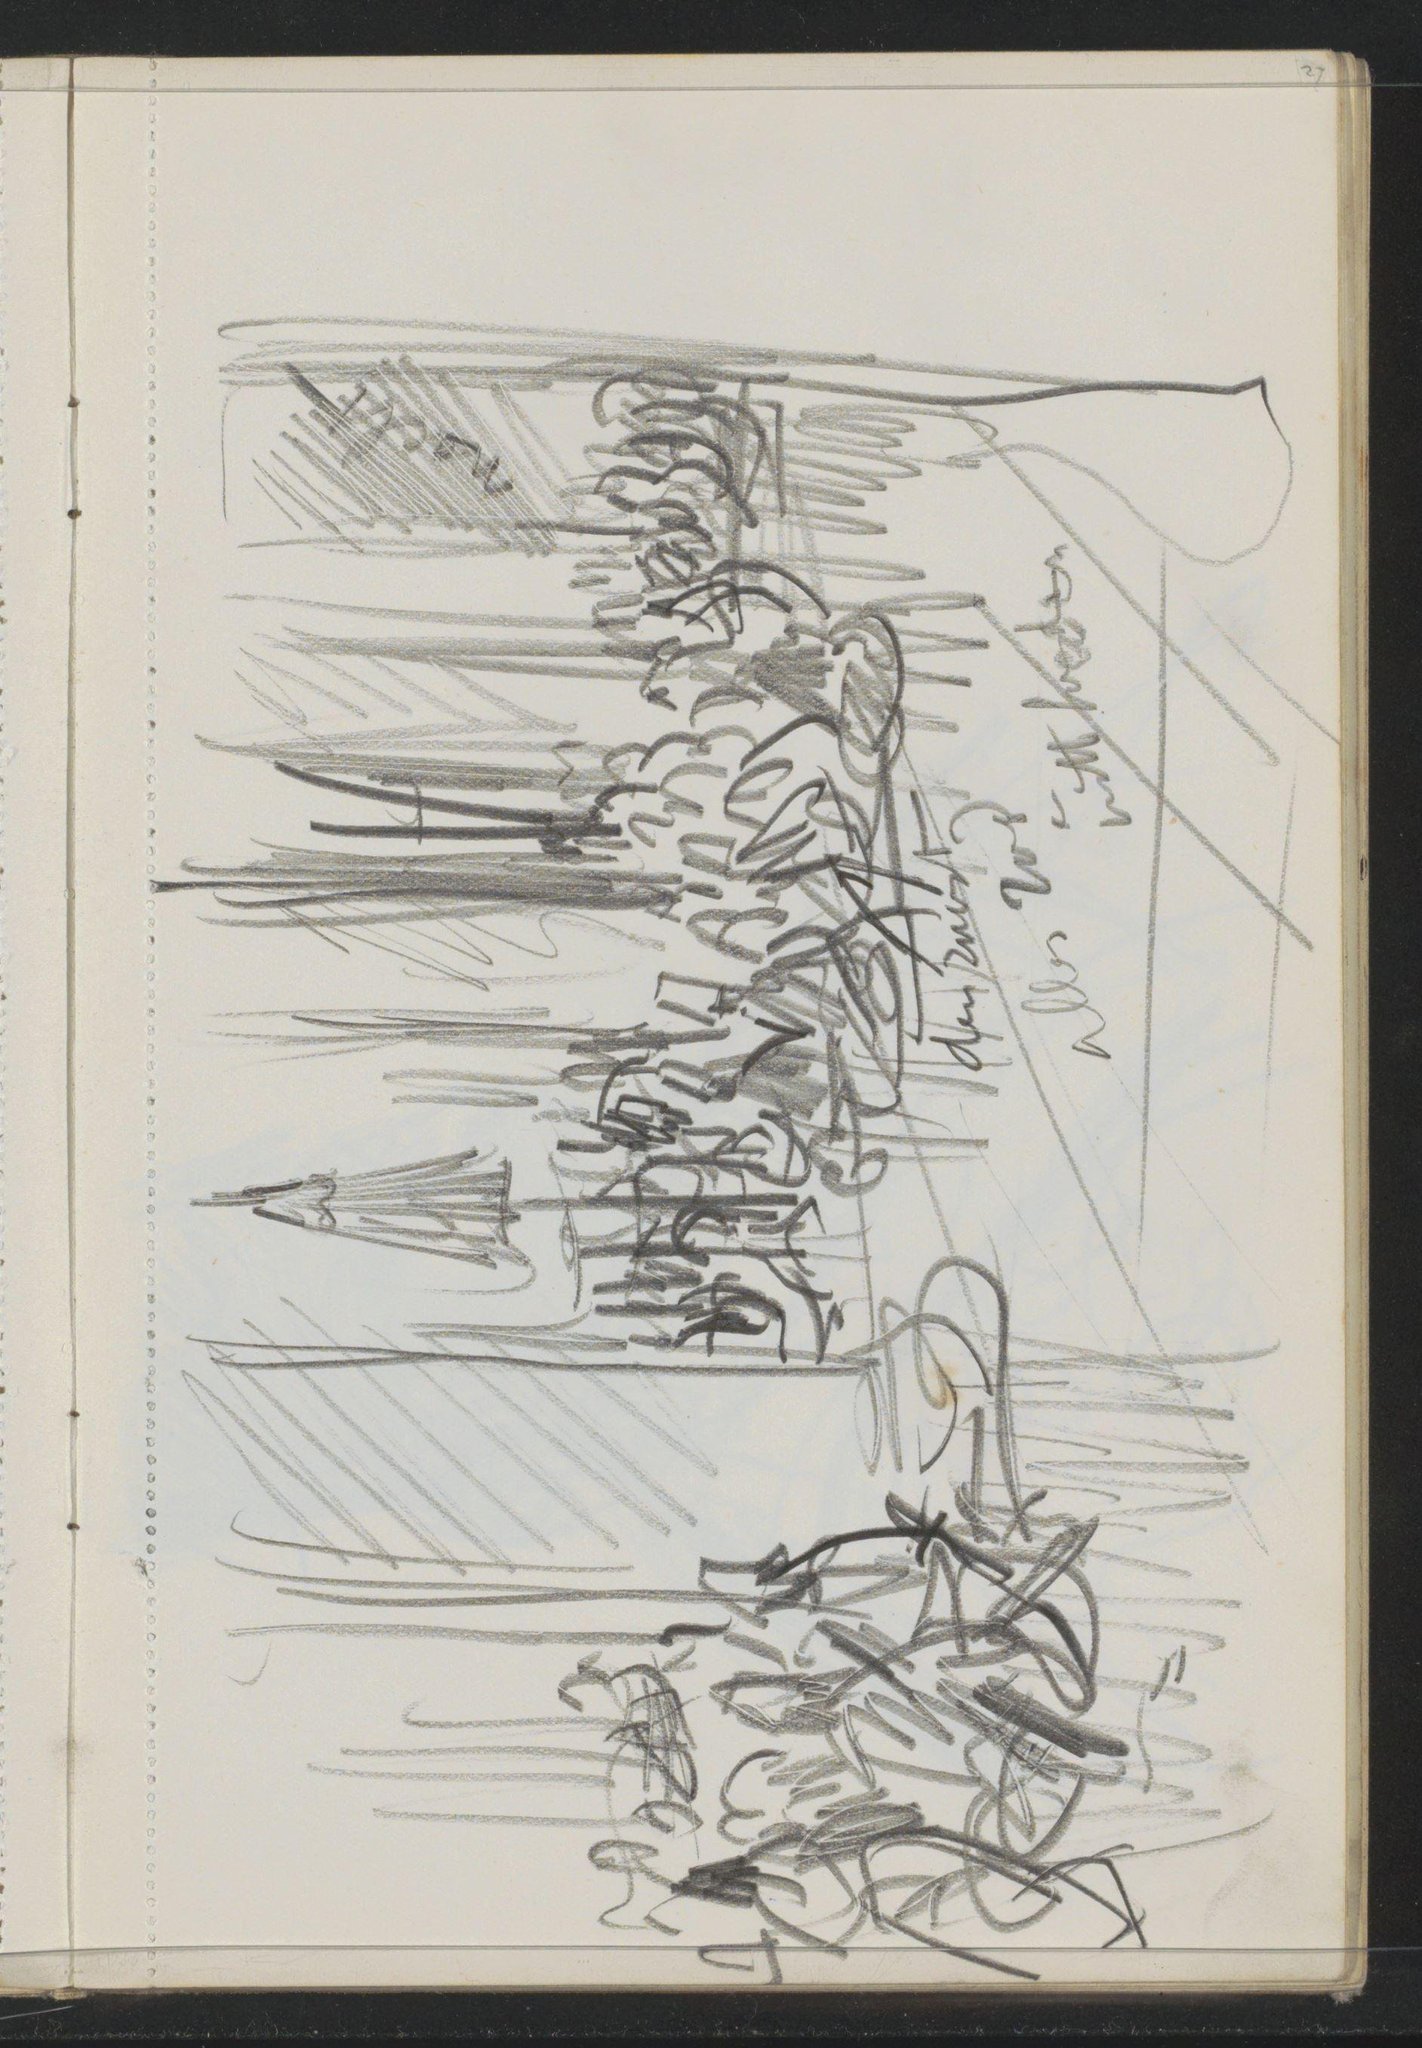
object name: sketchbook leaf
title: Hoogwaardigheidsbekleders aan het Hof van Djokja, zittend in een interieur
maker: marius bauer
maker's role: draughtsman, print maker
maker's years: 1867-1932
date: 1925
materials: paper, pencil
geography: indonesia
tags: sitting figure, folk costume, regional costume, interior ~ representation of a building, dignitary at court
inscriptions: kleurnotitie, handgeschreven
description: Pagina 27 uit een schetsboek met 74 bladen.